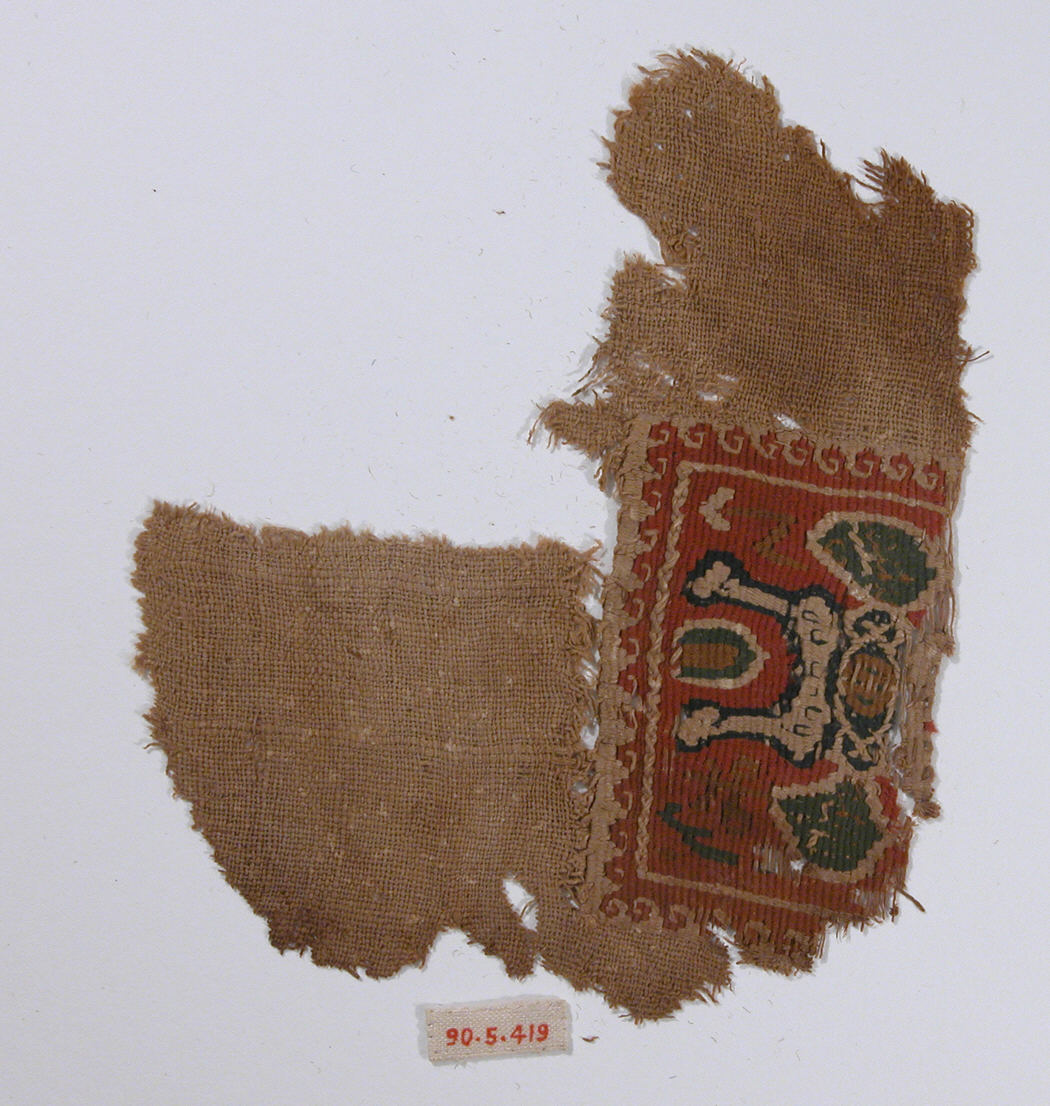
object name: textile fragment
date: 401-500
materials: linen, wool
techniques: weave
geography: egypt